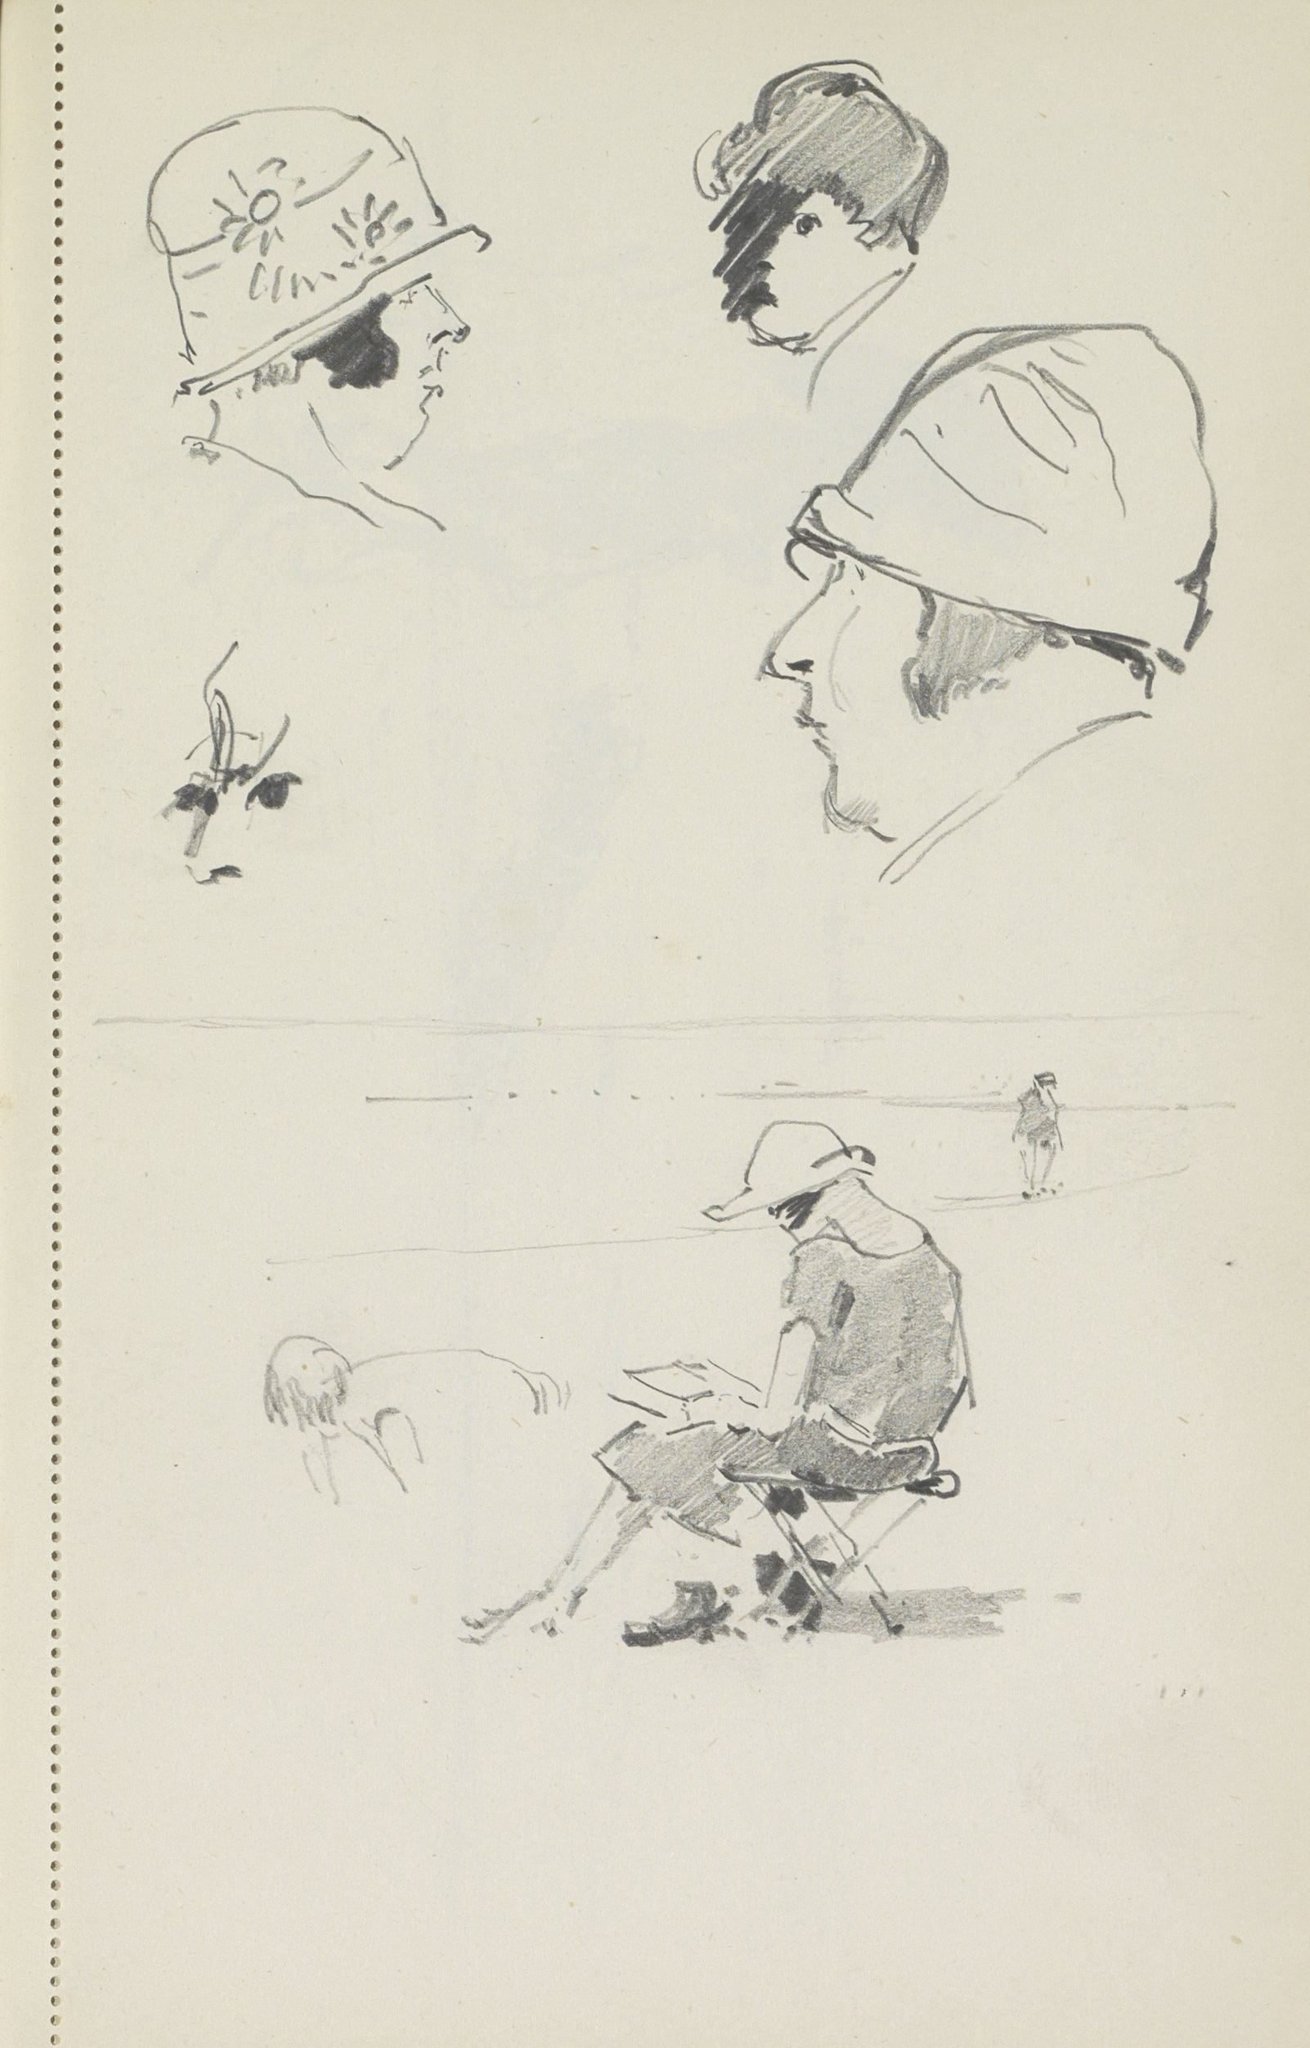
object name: sketchbook leaf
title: Lezende vrouw op een kruk aan het strand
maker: cornelis vreedenburgh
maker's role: draughtsman, print maker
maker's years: 1880-1946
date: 1890-1946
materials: paper, pencil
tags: reading, head (human) - aa - female human figure, beach (+ landscape with figures, staffage)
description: Tevens studies van vrouwenkoppen met hoeden. Blad 32 recto uit een schetsboek met 50 bladen.